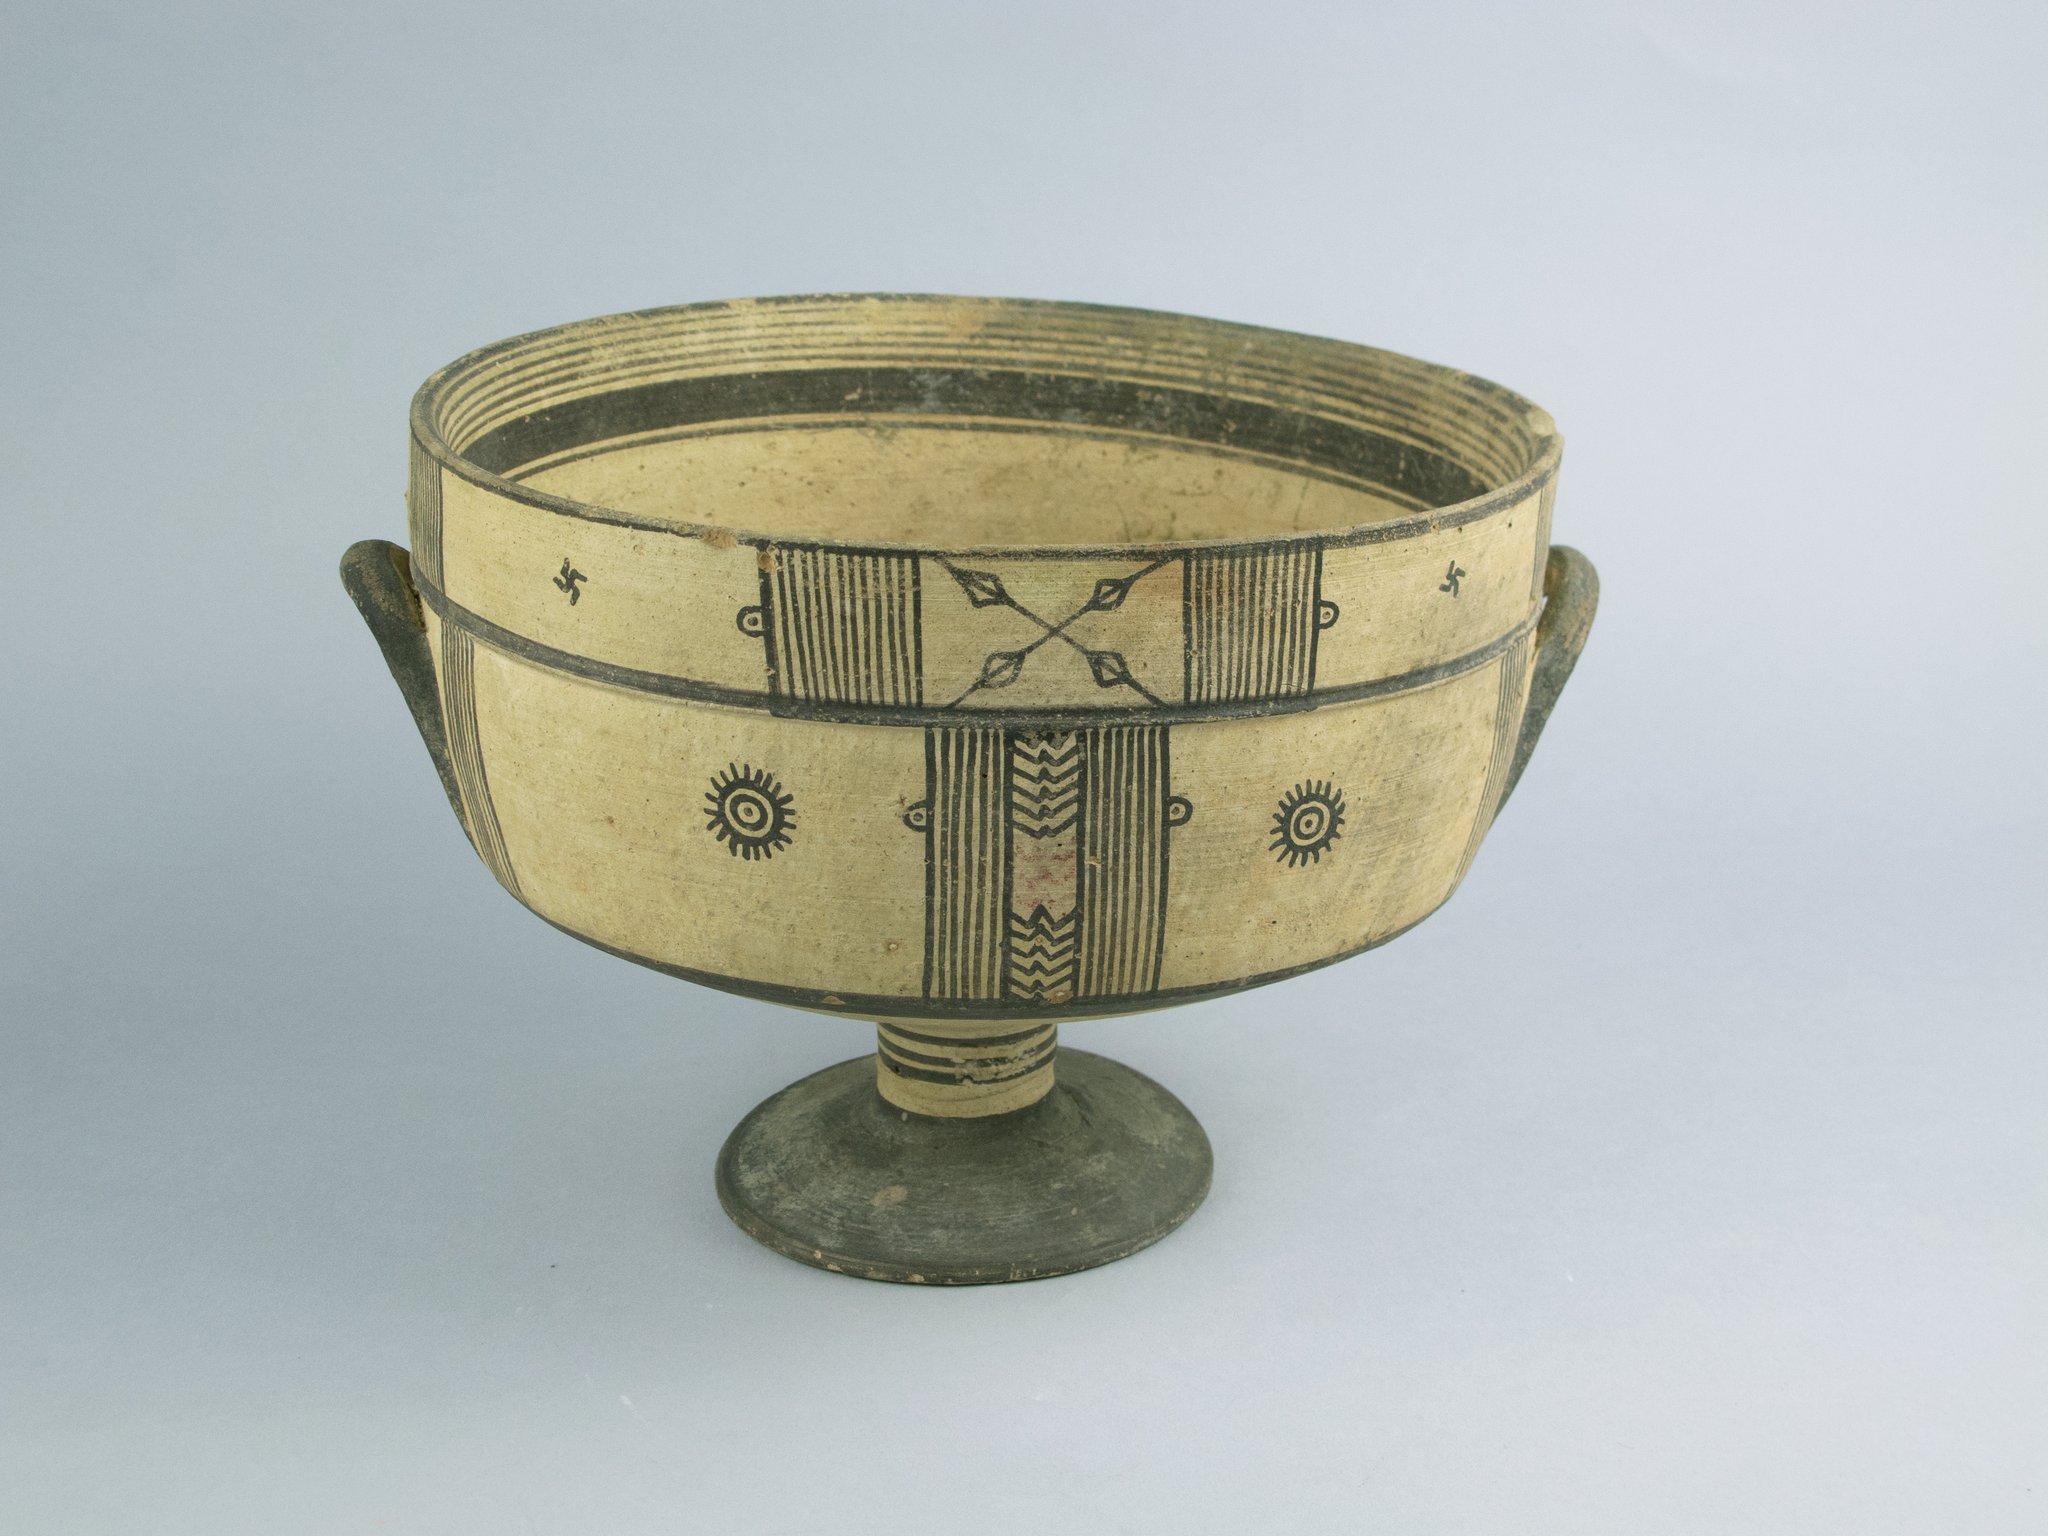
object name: kylix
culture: cypriot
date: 750-600 BCE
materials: terracotta